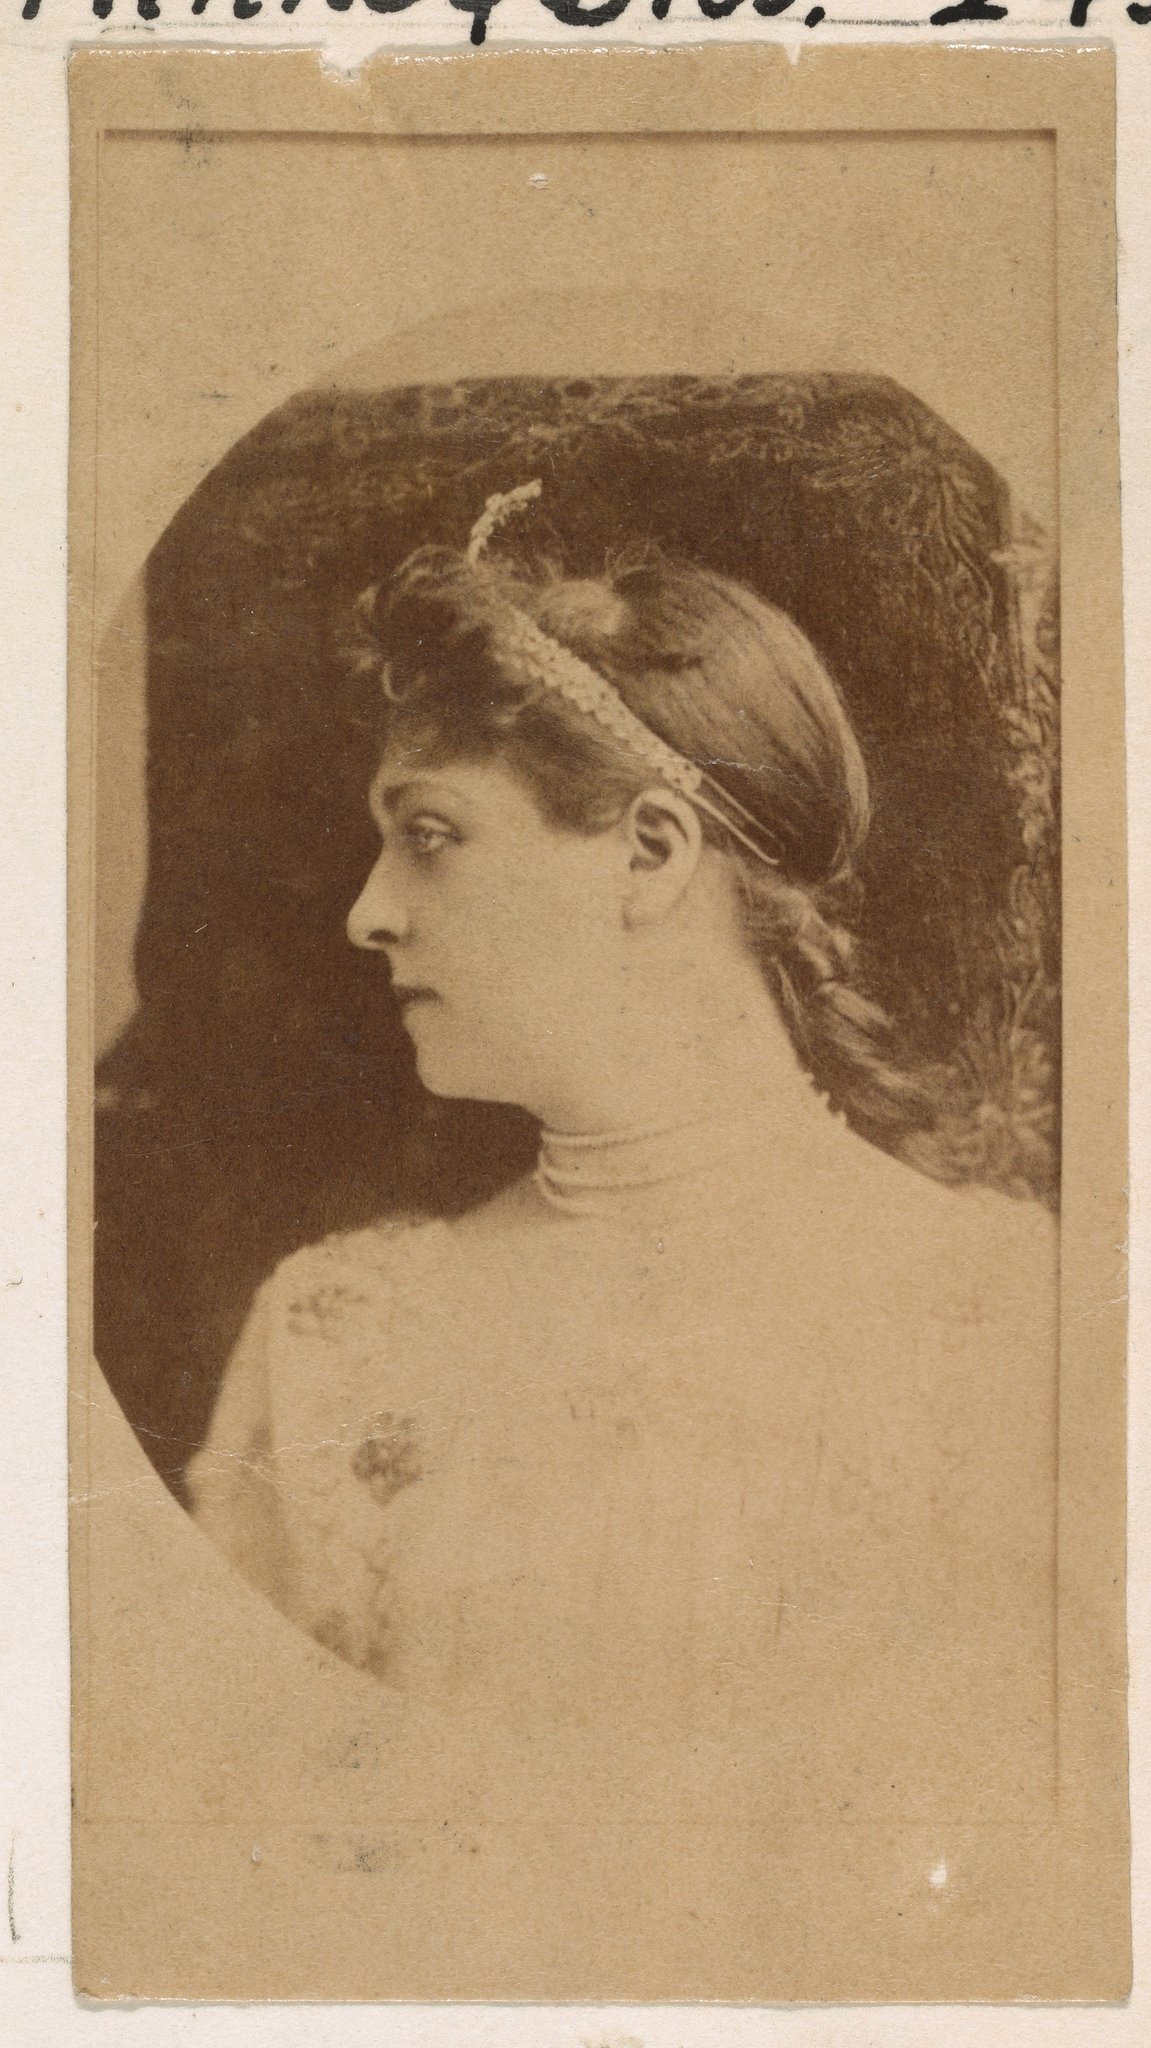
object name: photograph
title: Actress in profile wearing simple headpiece, from the Actresses series (N245) issued by Kinney Brothers to promote Sweet Caporal Cigarettes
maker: kinney brothers tobacco company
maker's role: publisher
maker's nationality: american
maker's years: 1869-2011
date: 1890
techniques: albumen silver print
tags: women,actresses